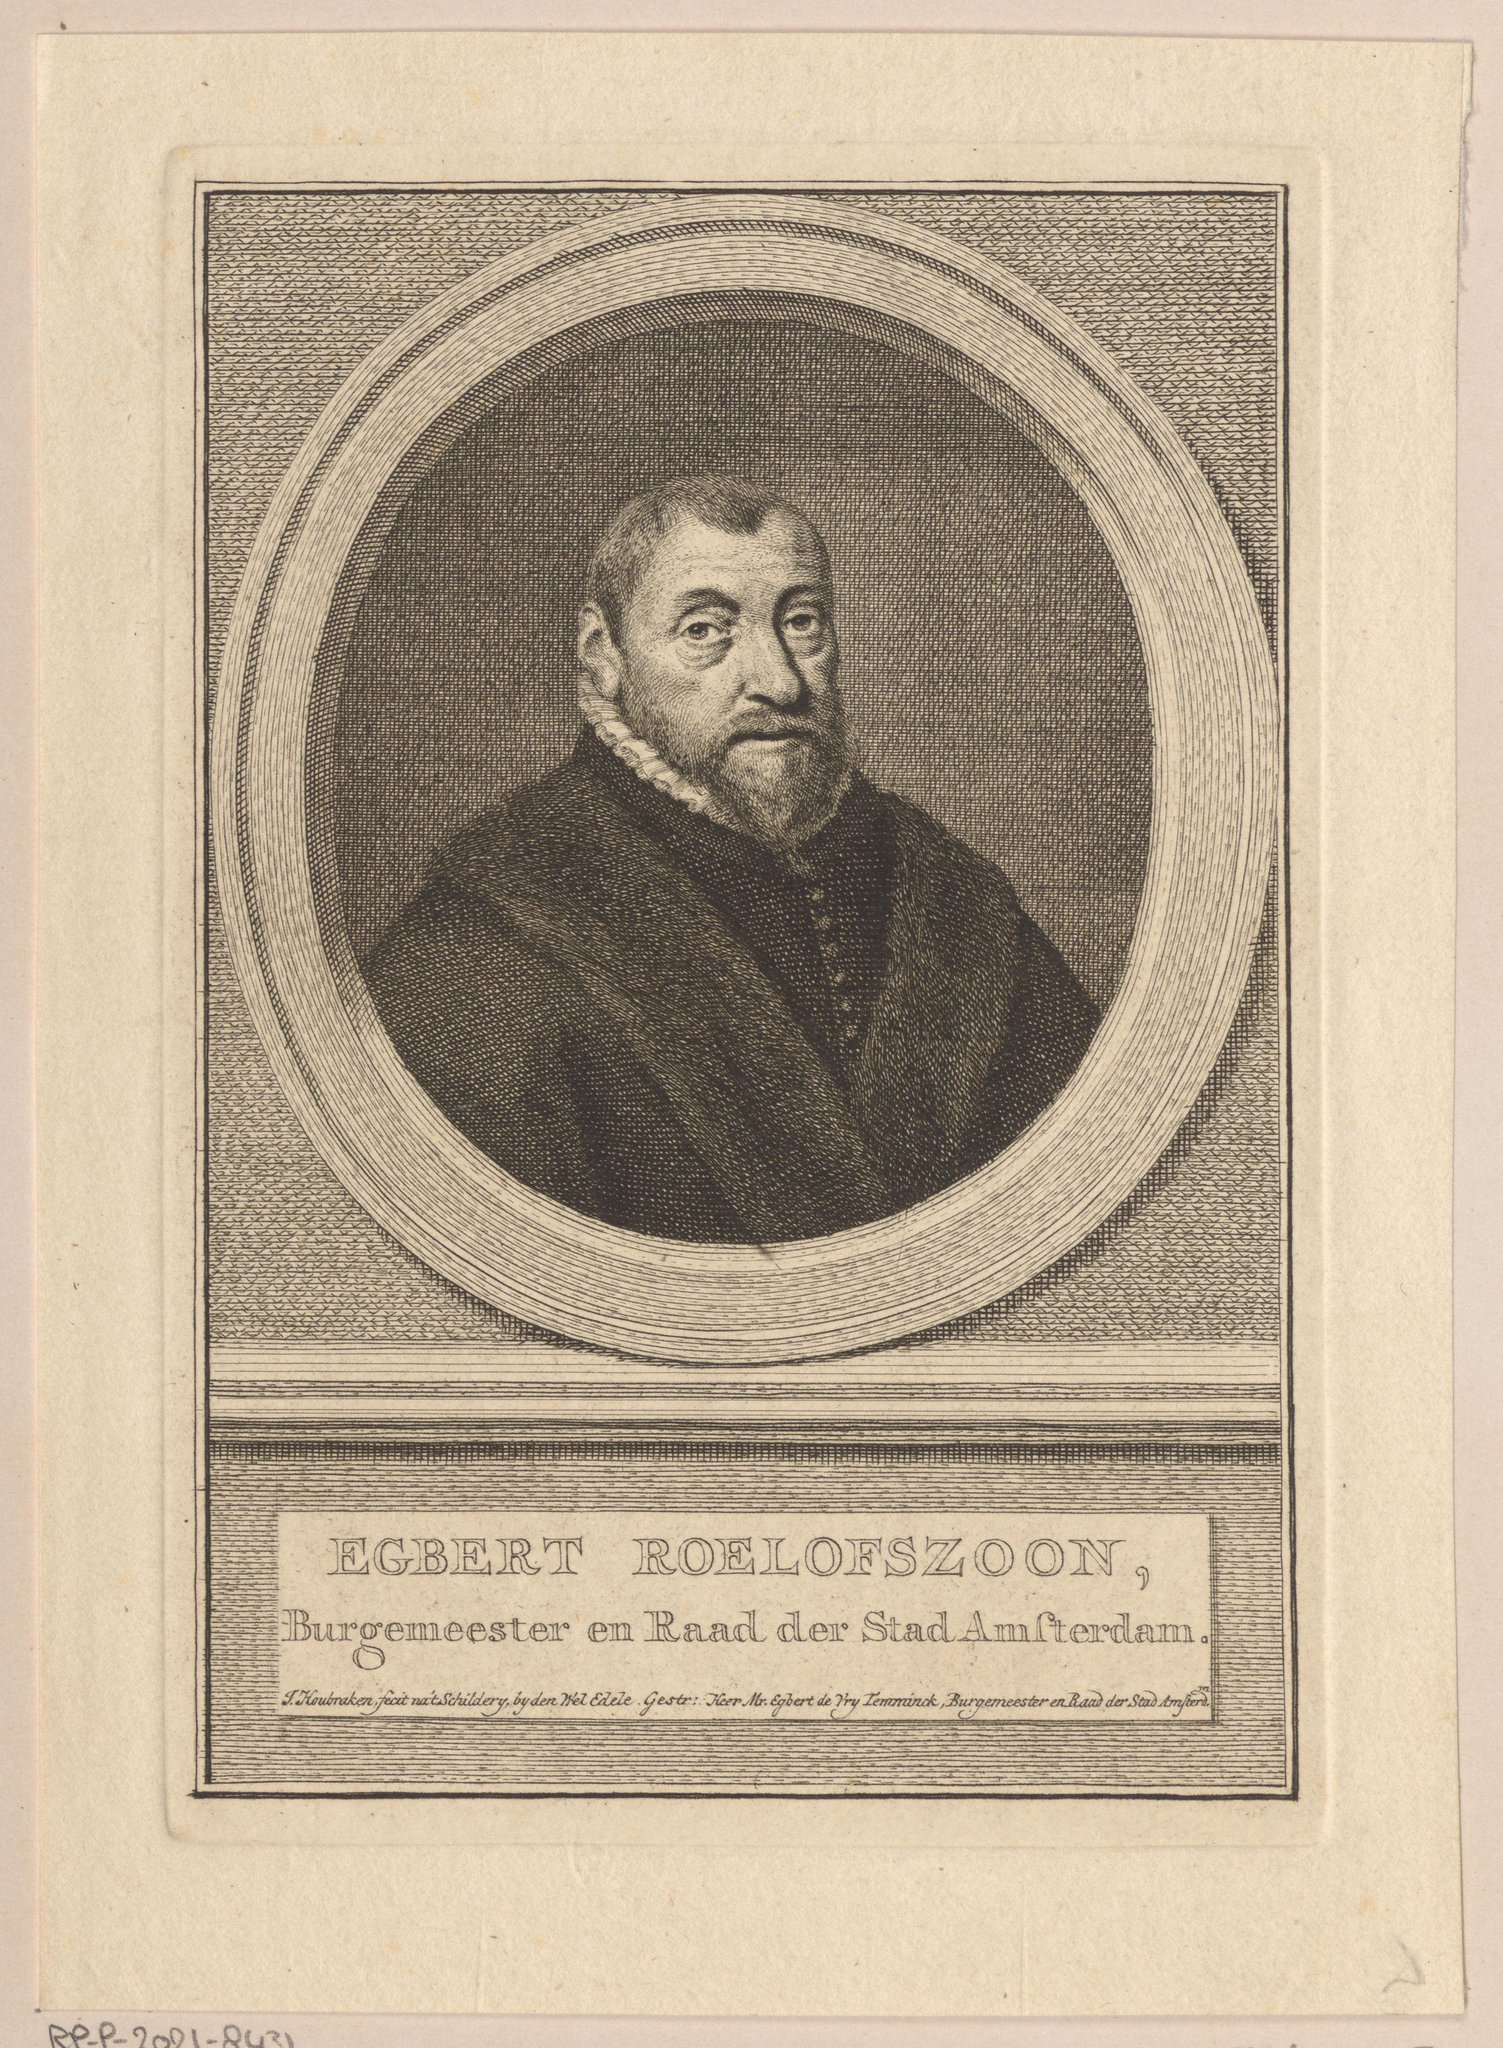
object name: print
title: Portret van Egbert Roelofszoon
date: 1749-1792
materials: paper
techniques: engraving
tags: historical persons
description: Prent mogelijk uit: Wagenaar, Jan. Vaderlandsche historie, vervattende de geschiedenissen der Vereenigde Nederlanden (…). 21 dln. Amsterdam: Isaak Tirion, 1749-1759. Of uit een latere publicatie (1770, 1792).